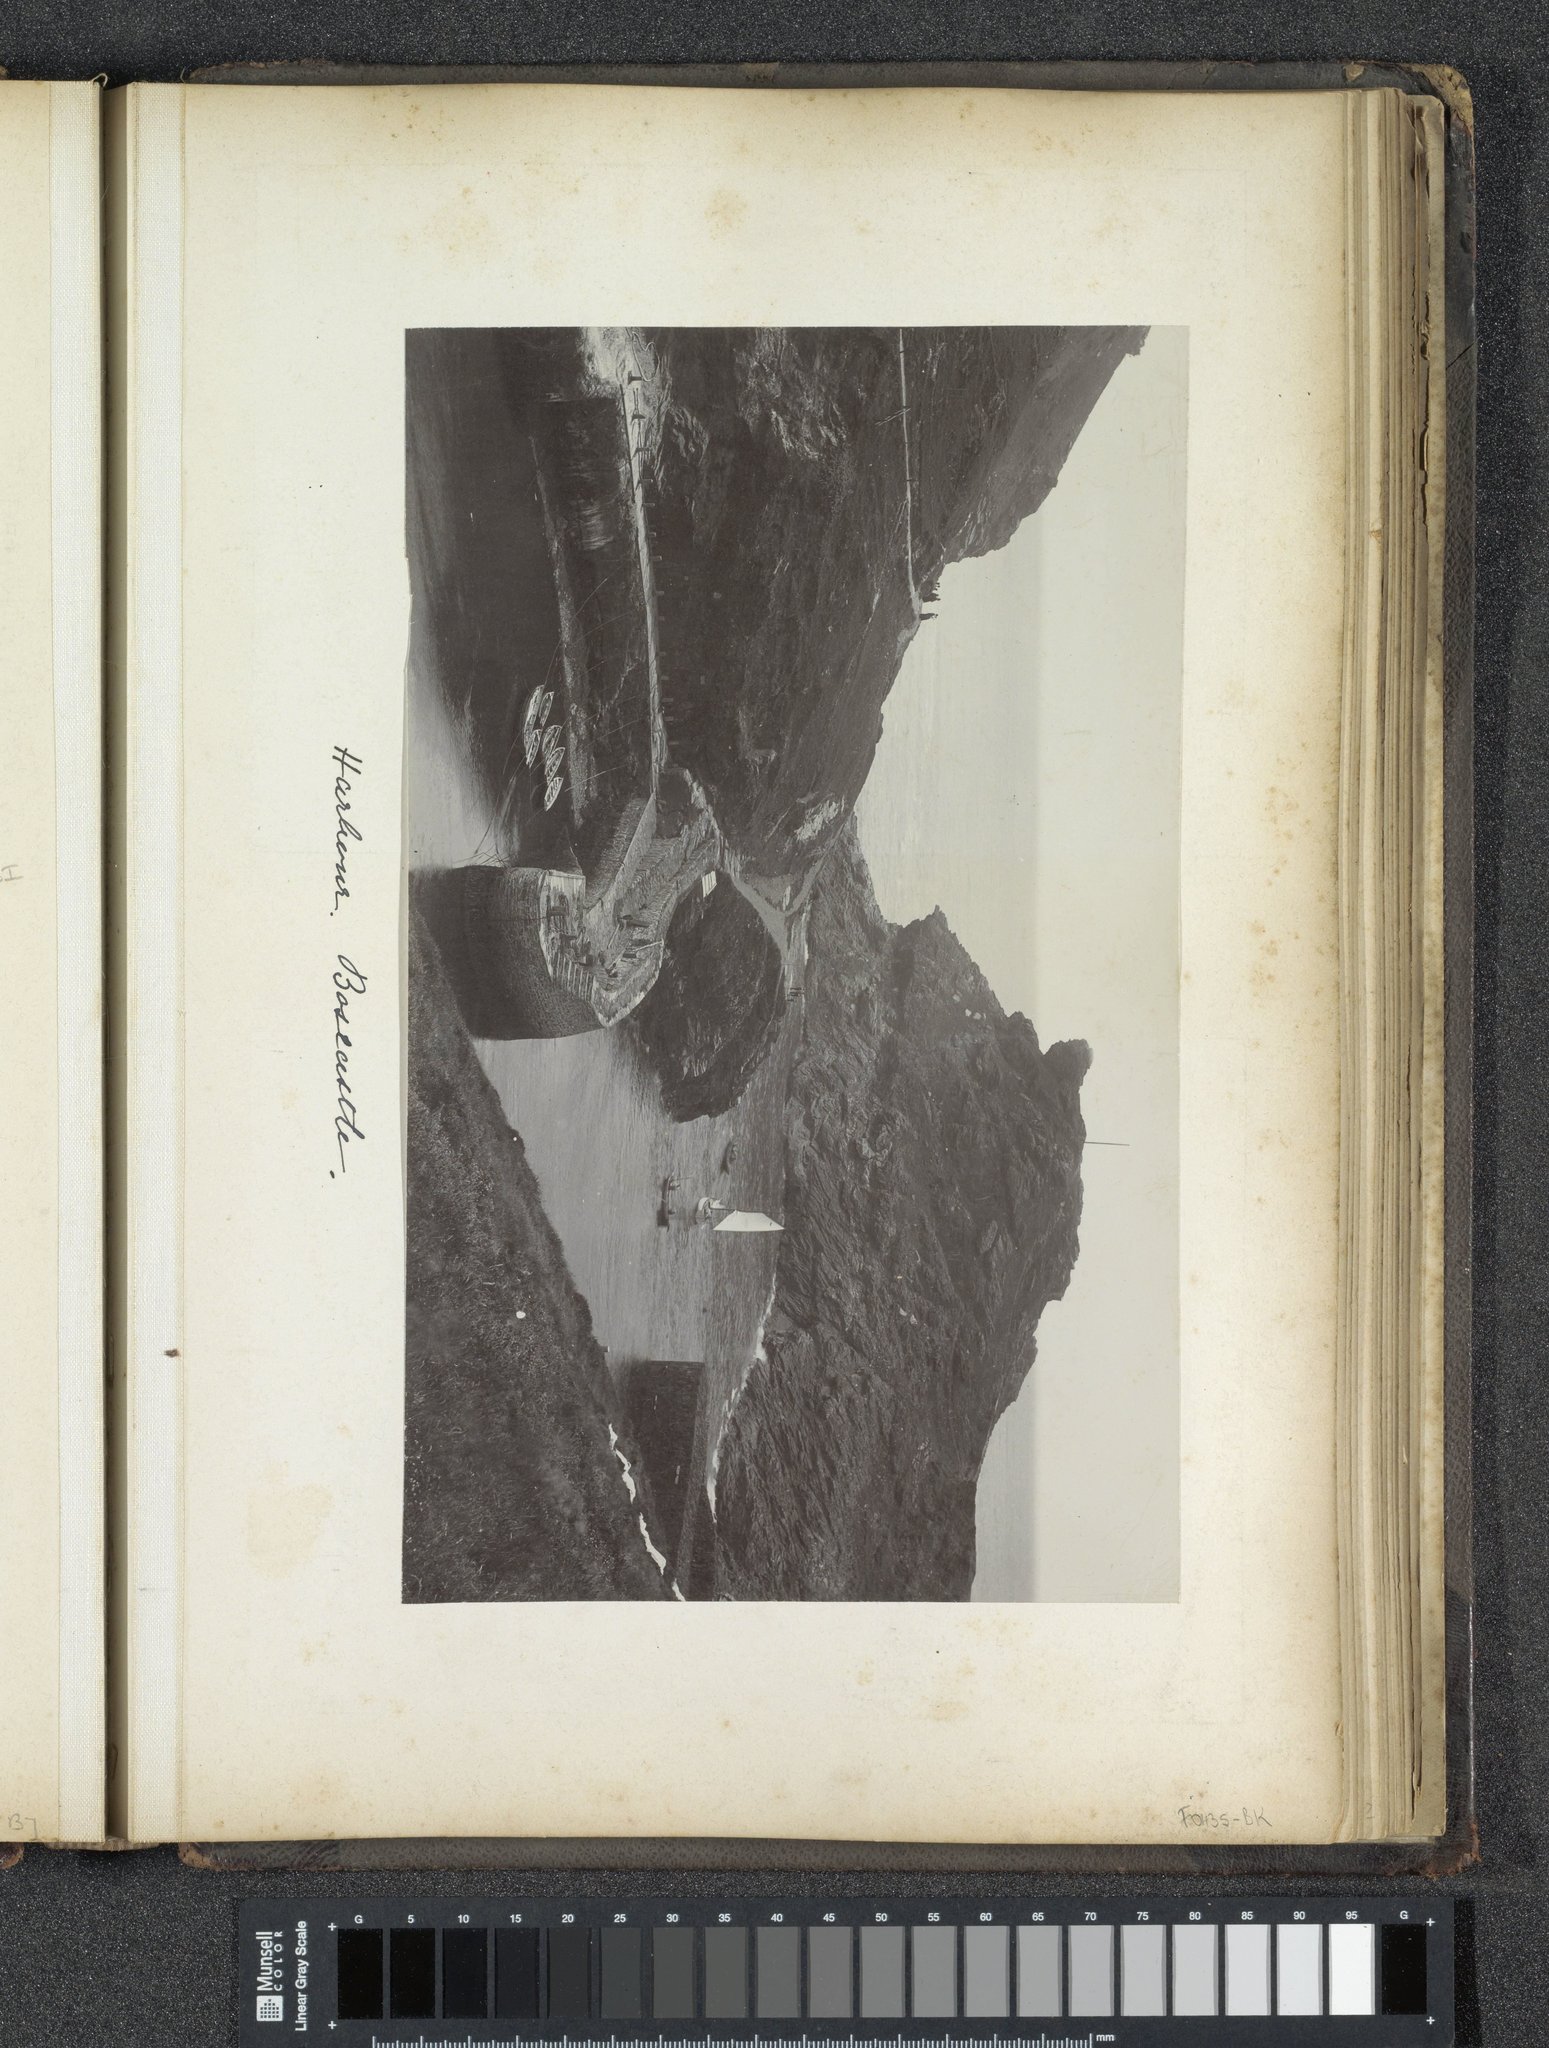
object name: photograph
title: Gezicht op de haven van Boscastle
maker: Anonymous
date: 1899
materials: paper, photographic support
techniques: daylight paper print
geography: boscastle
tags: harbour (+ view ~ vehicle, ship, etc.)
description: Onderdeel van Reisalbum met foto's van bezienswaardigheden in Engeland en Frankrijk.